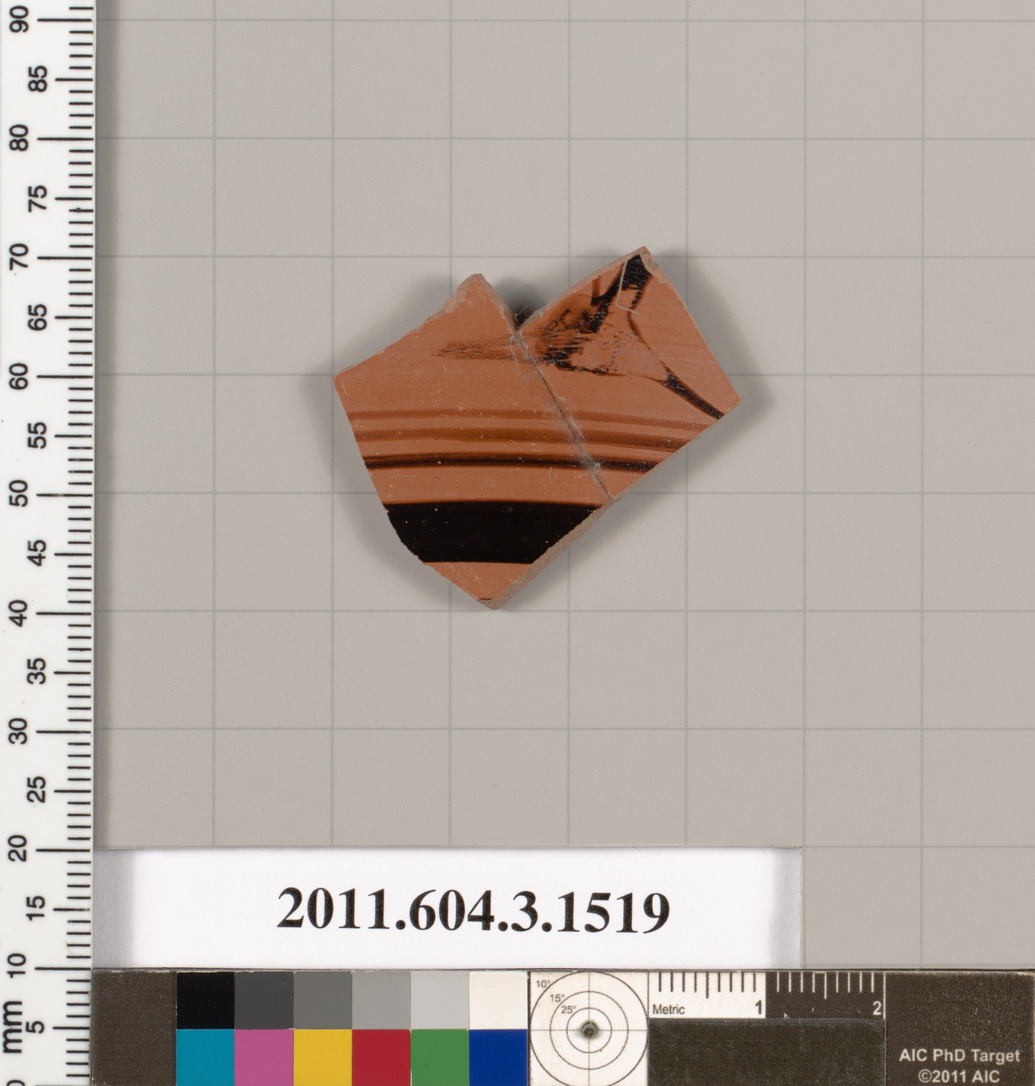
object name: skyphos fragment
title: Terracotta fragment of a skyphos (deep drinking cup)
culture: greek, attic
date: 534-468 BCE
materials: terracotta